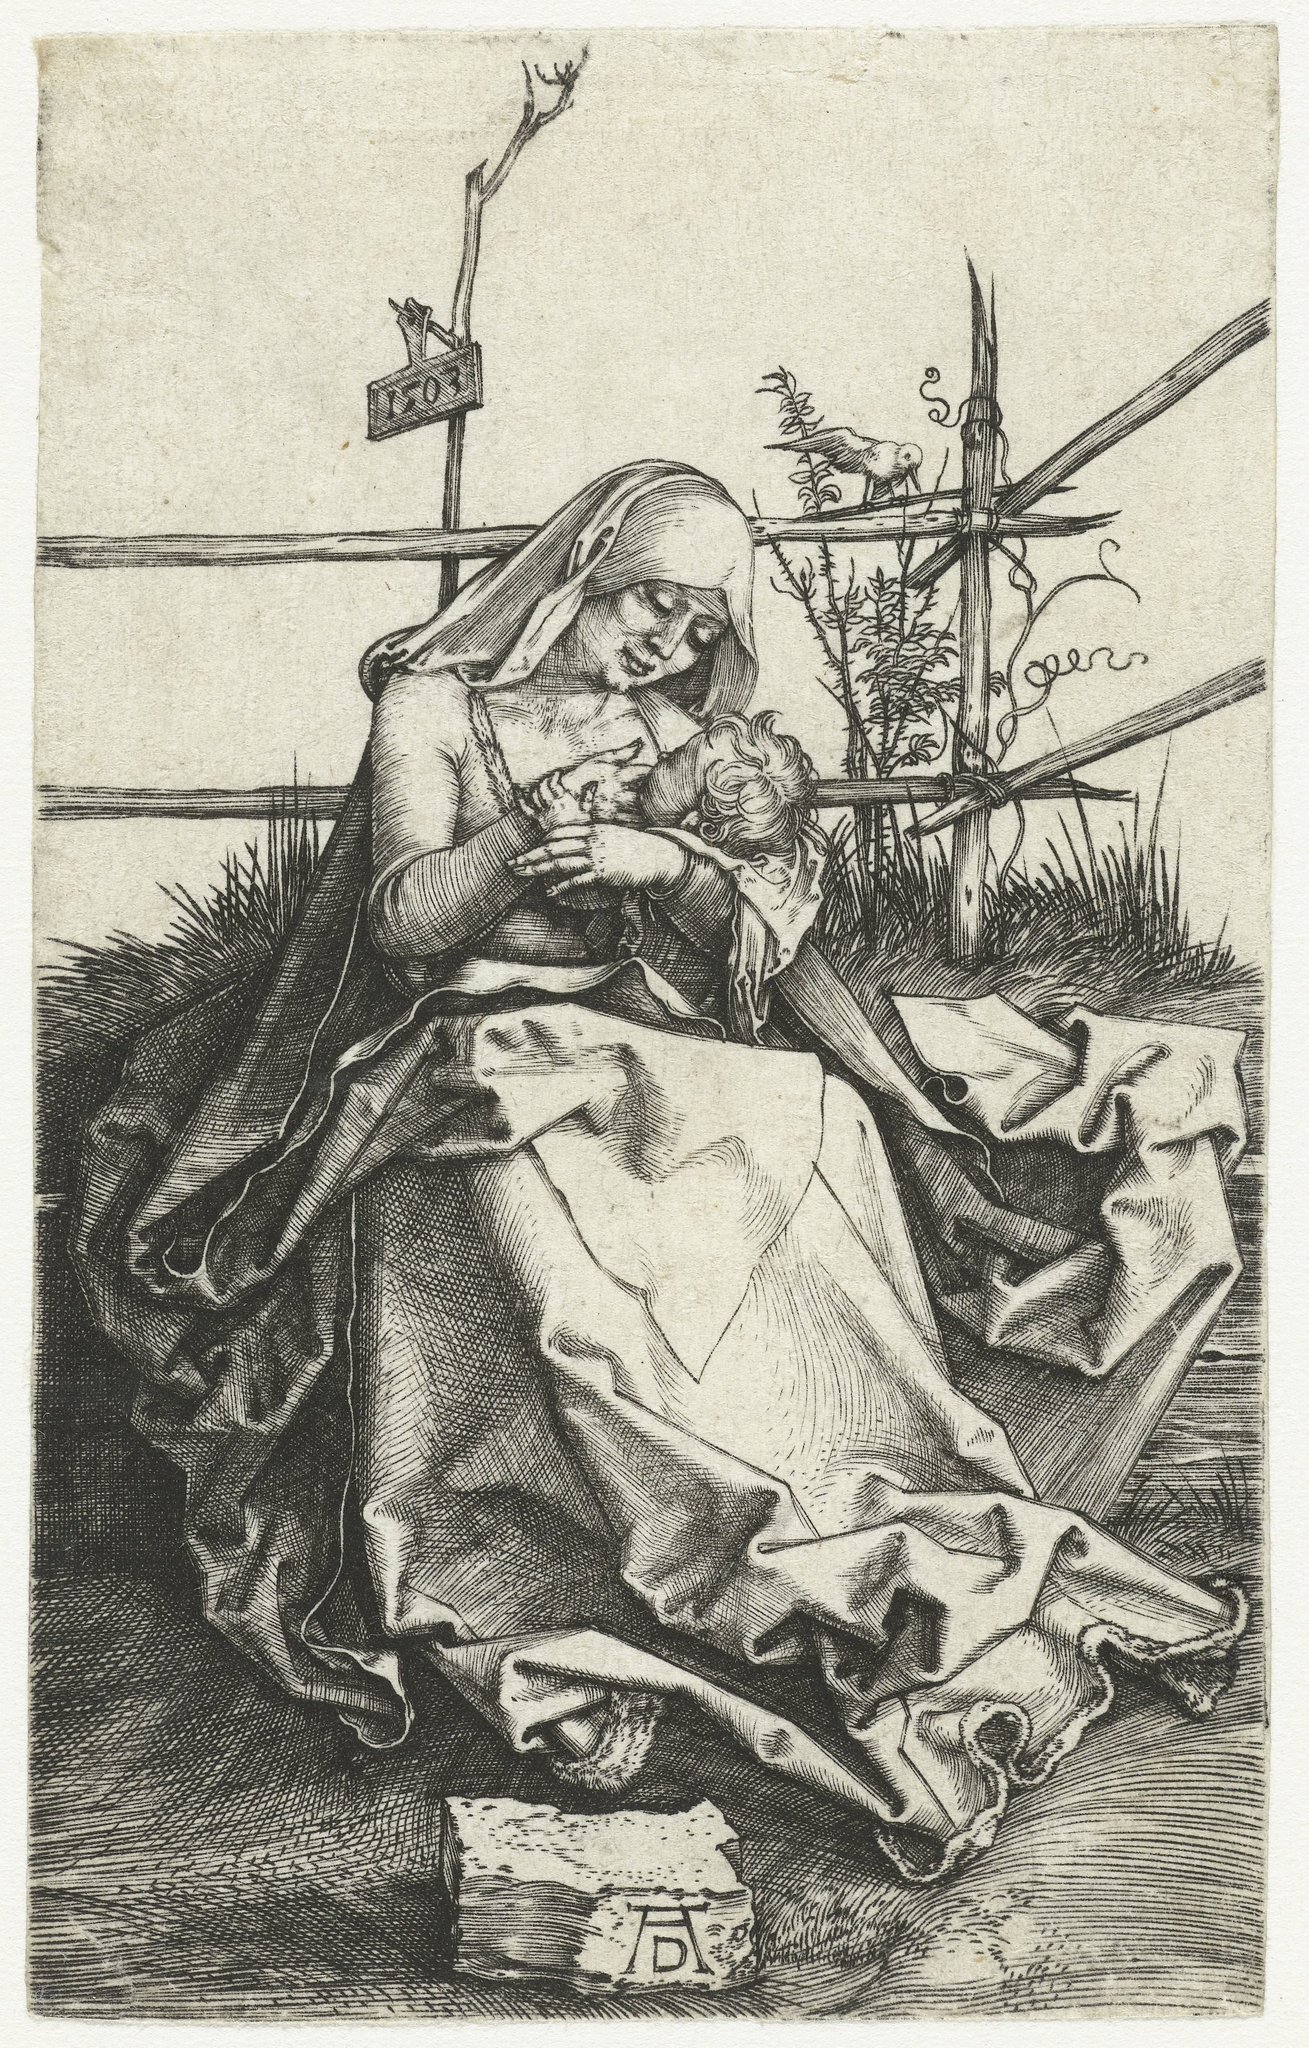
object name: print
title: Maria met kind aan de borst bij een hek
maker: albrecht dürer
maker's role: draughtsman, painter, print maker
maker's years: 1471-1528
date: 1503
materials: paper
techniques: engraving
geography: nuremberg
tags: christ-child suckling, or beginning to suckle, e.g. mary uncovering her breast ~ madonna-representations, mary sitting or enthroned, the christ-child in front of her in her lap (or in front of her bosom)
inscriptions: collector's mark: Lugt 2228a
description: Maria zit op het gras bij een houten hekje en zoogt het Christuskind aan de linkerborst.